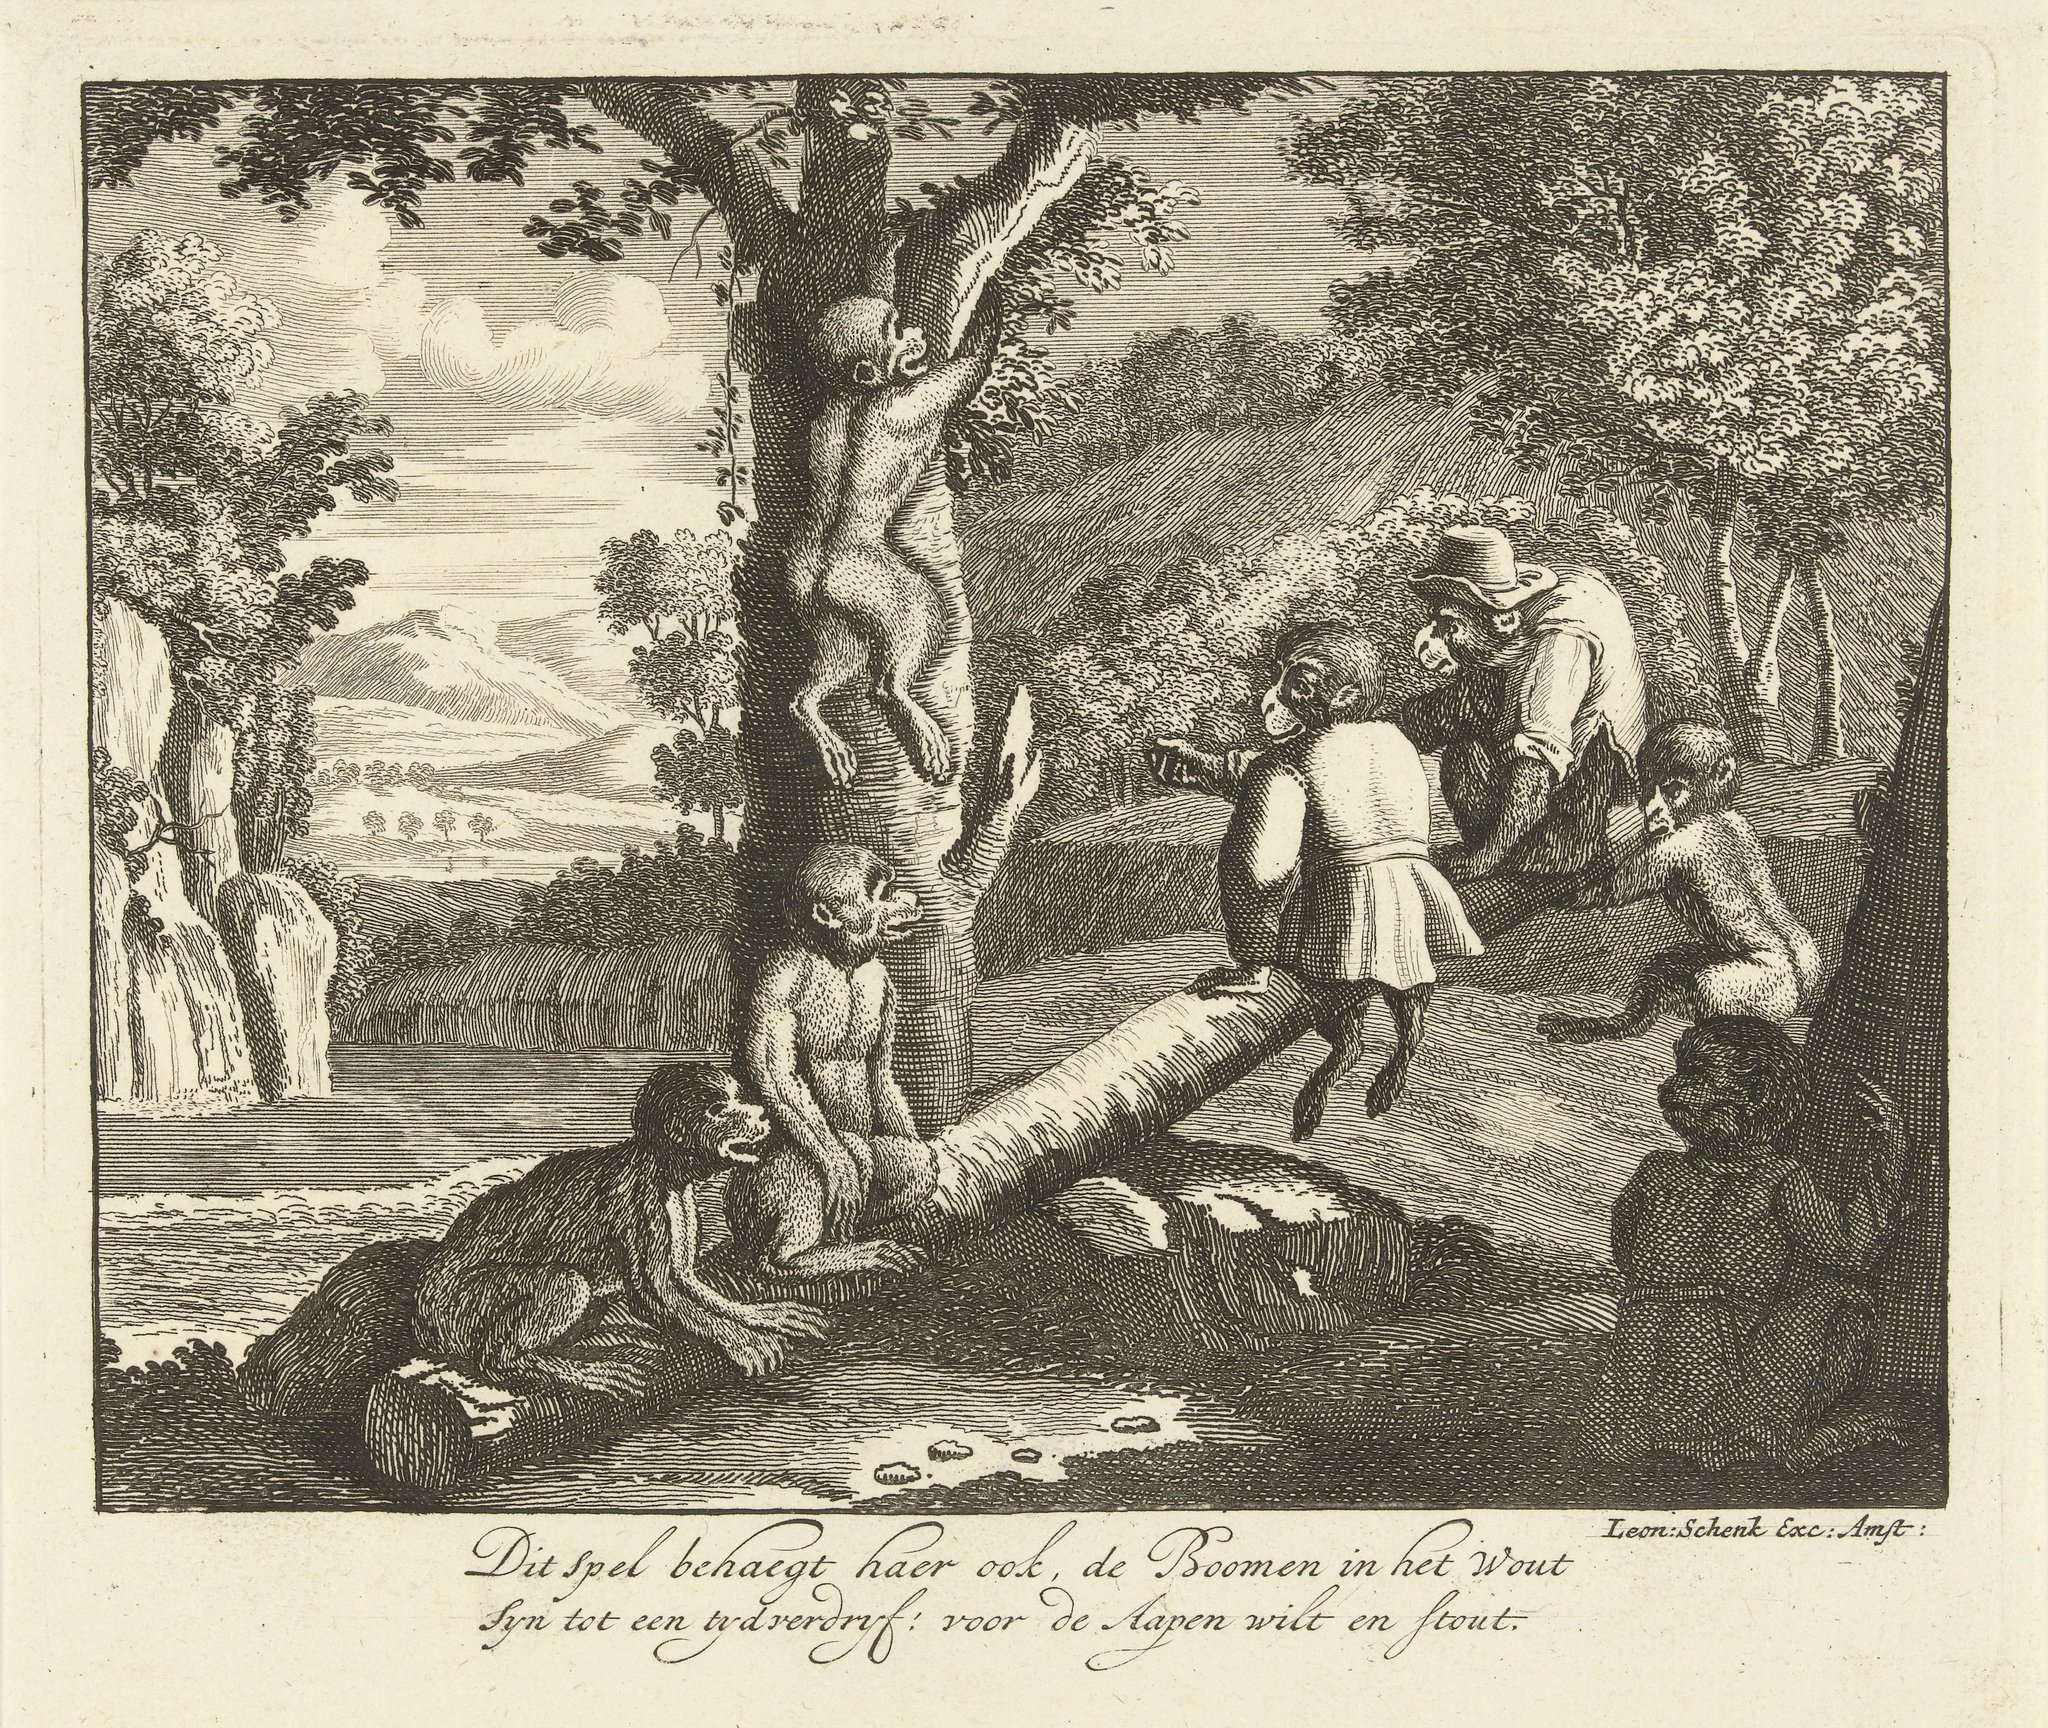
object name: print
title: 't Aapenspel in de Werelt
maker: leonard schenk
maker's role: print maker, publisher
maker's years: 1696-1767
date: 1720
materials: paper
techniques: engraving, etching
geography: amsterdam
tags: monkeys, apes, animals acting as human beings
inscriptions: collector's mark: Lugt 2228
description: Jonge apen spelen in het bos op de wip en in de boom. Onderdeel van een serie bestaande uit een titelprent met 16 ongenummerde platen uit ca. 1720 waarin apen als mensen figureren in allerlei taferelen uit het dagelijks leven. Elke prent met een tweeregelig vers in het onderschrift.